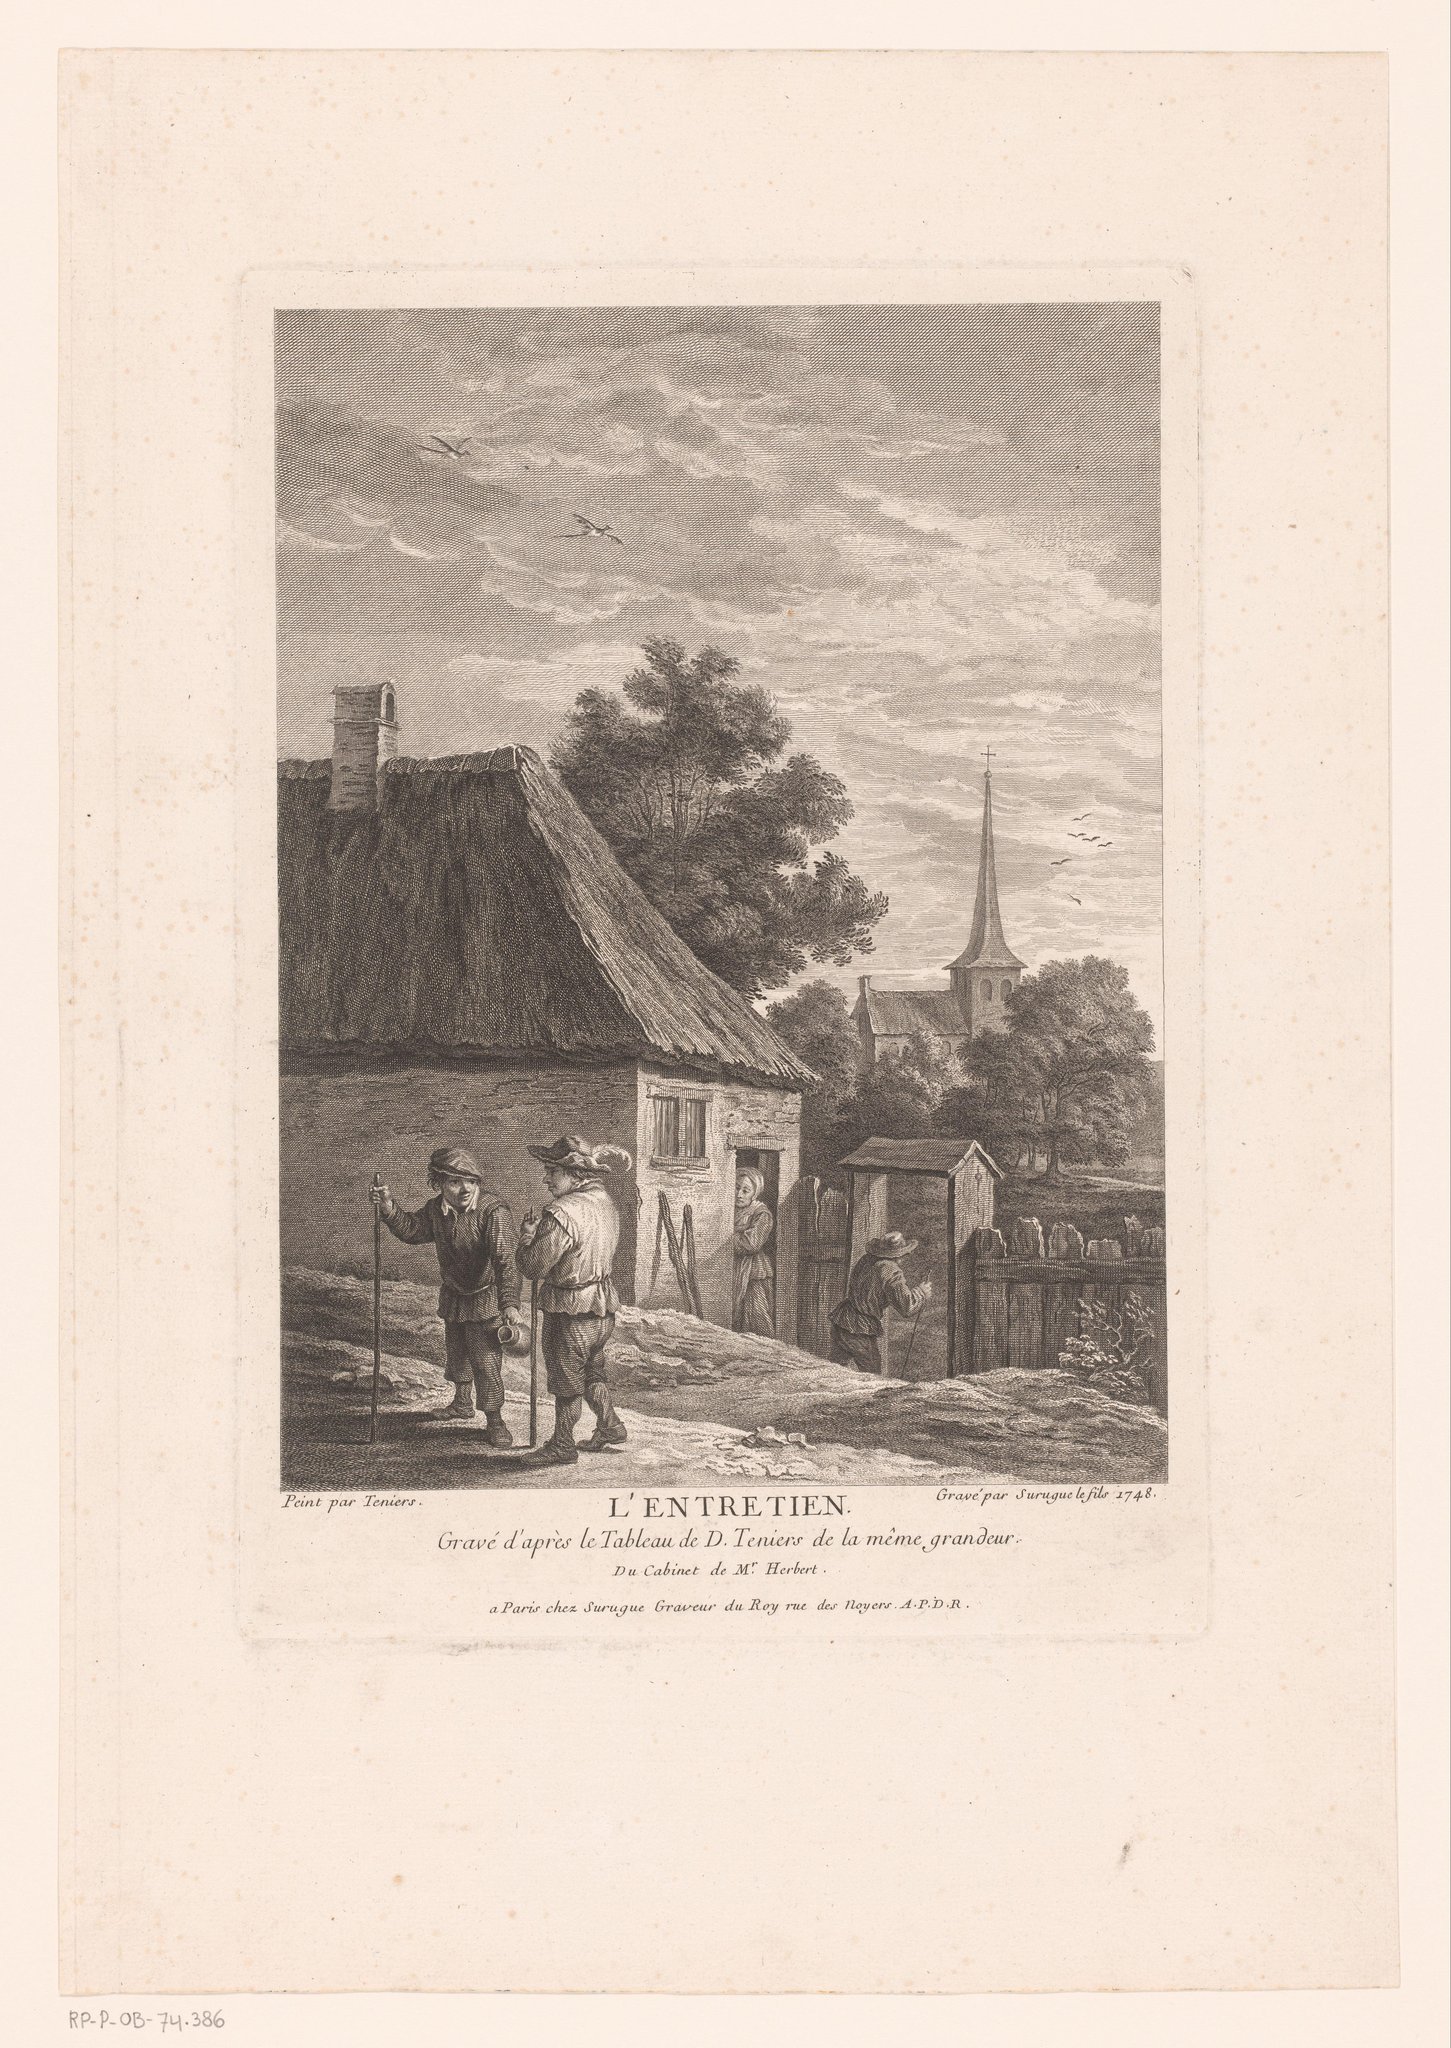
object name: print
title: L'Entretien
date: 1748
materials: paper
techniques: engraving, etching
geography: paris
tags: village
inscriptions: collector's mark: Lugt 240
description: Links vooraan twee mannen in gesprek, daarachter een huis met een vrouw in de deuropening. Rechts op de achtergrond een kerktoren.